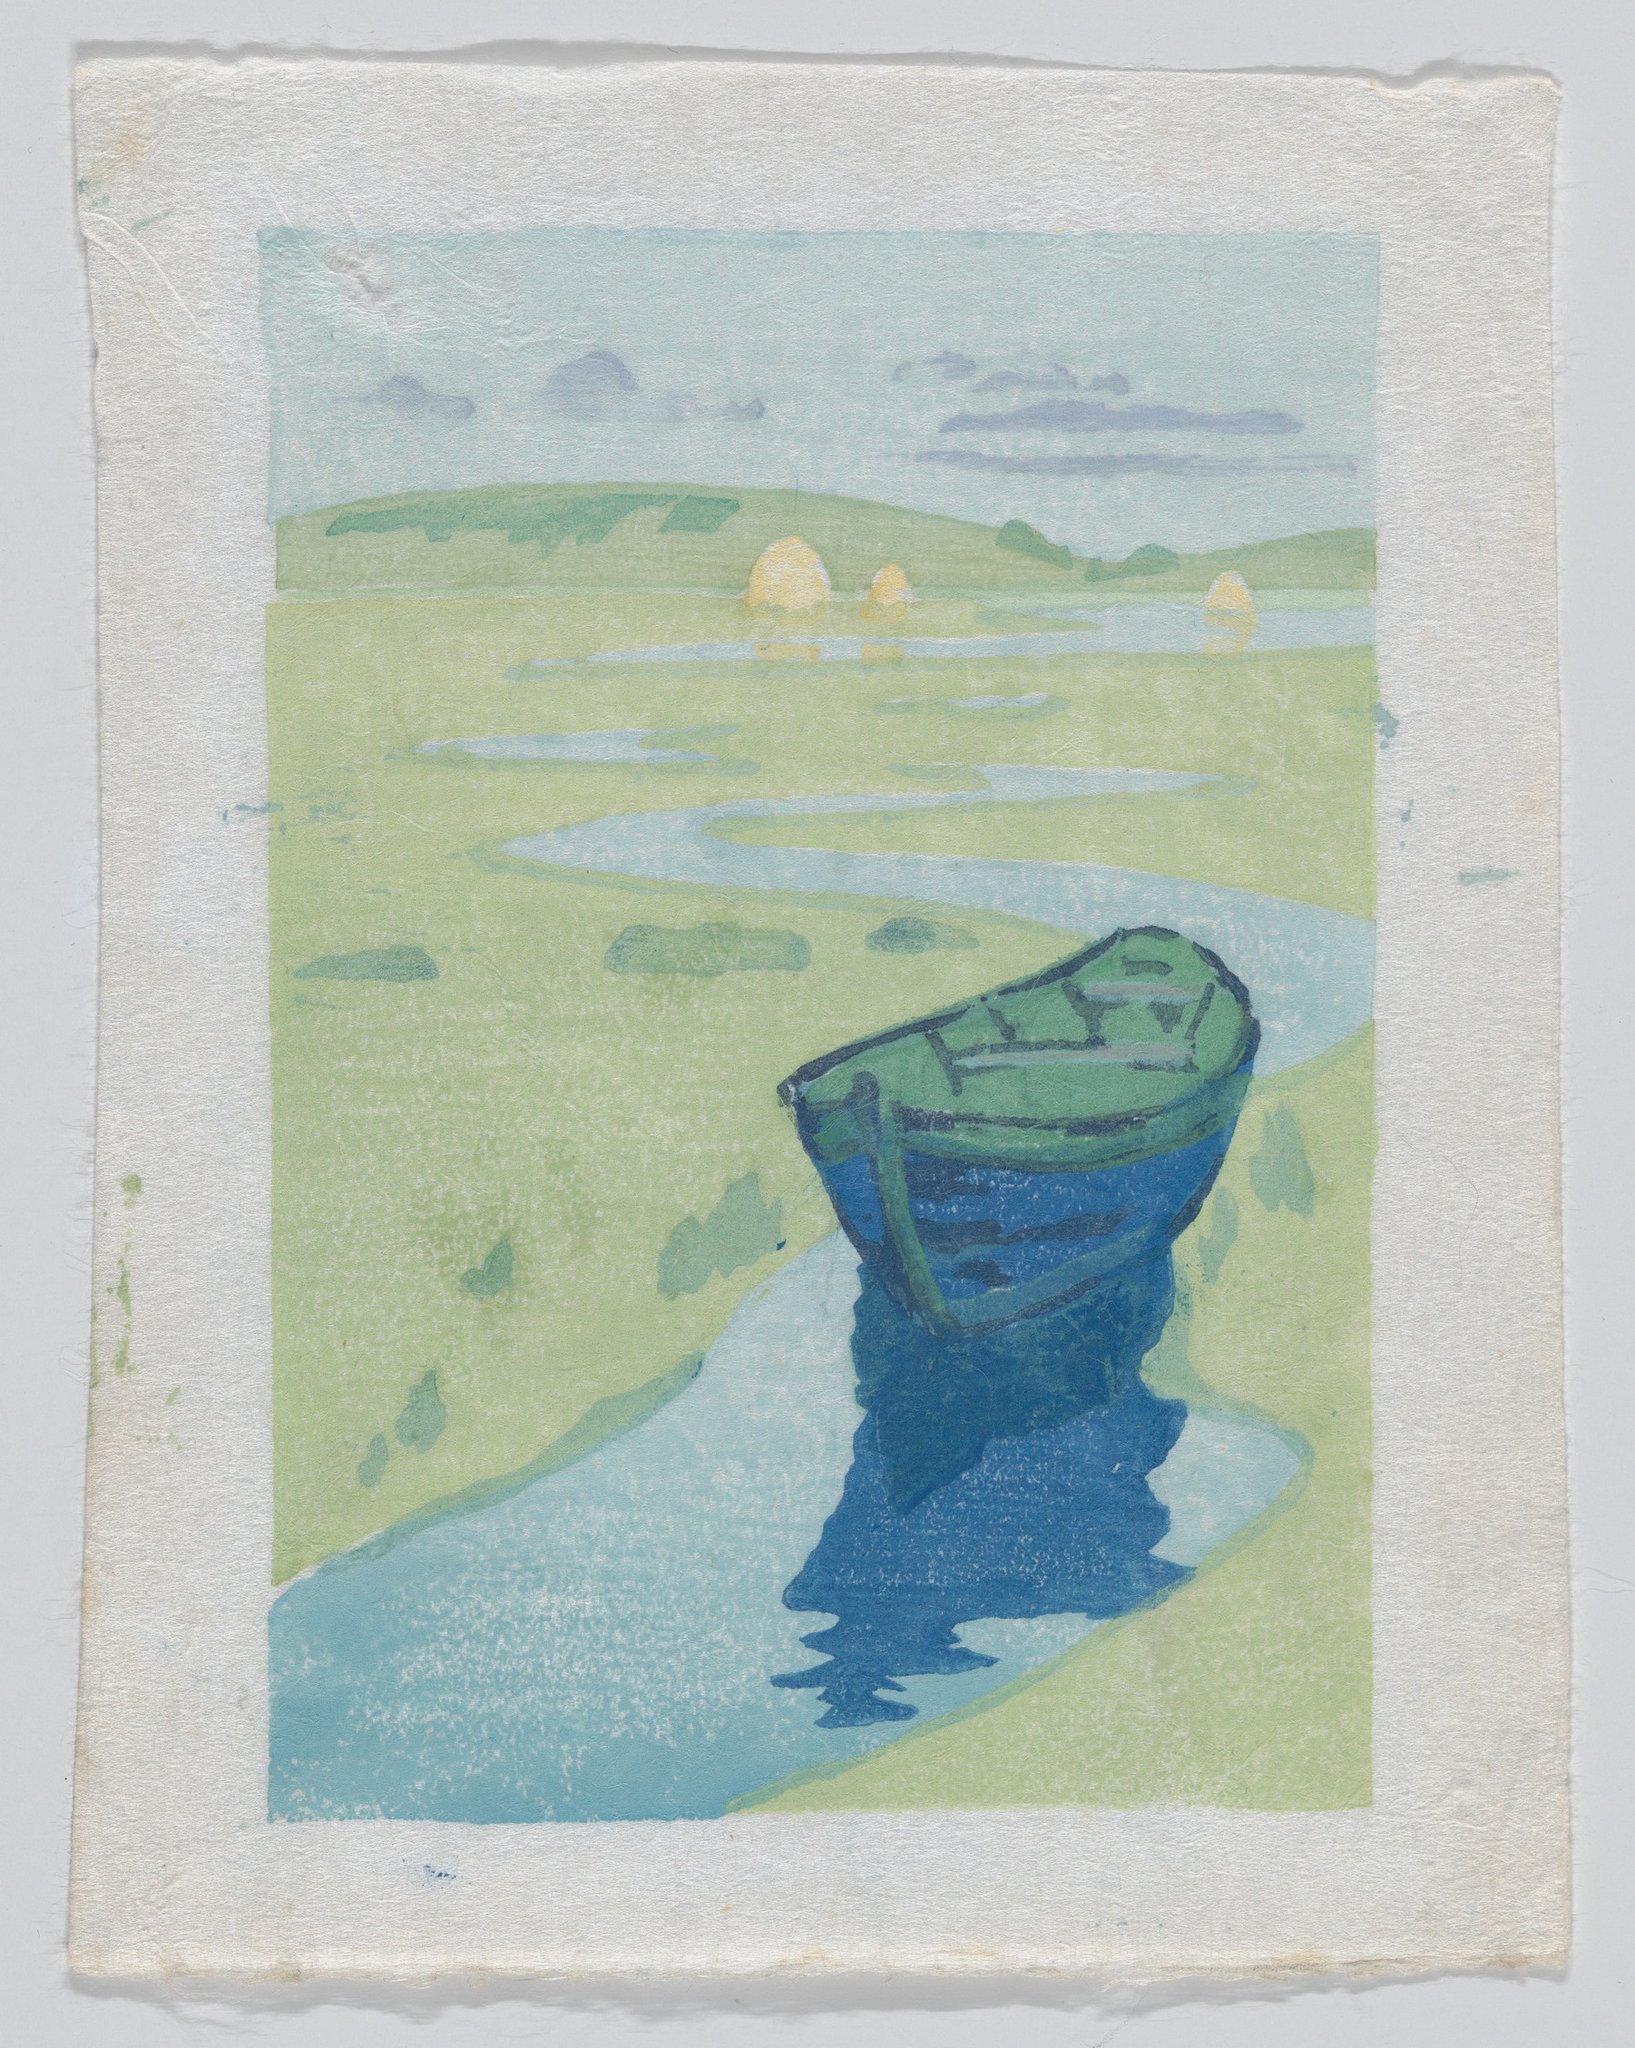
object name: woodcut, print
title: "The Derelict" or "The Lost Boat"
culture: american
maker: arthur wesley dow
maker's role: artist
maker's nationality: american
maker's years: 1857-1922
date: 1916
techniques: woodcut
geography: united states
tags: boats